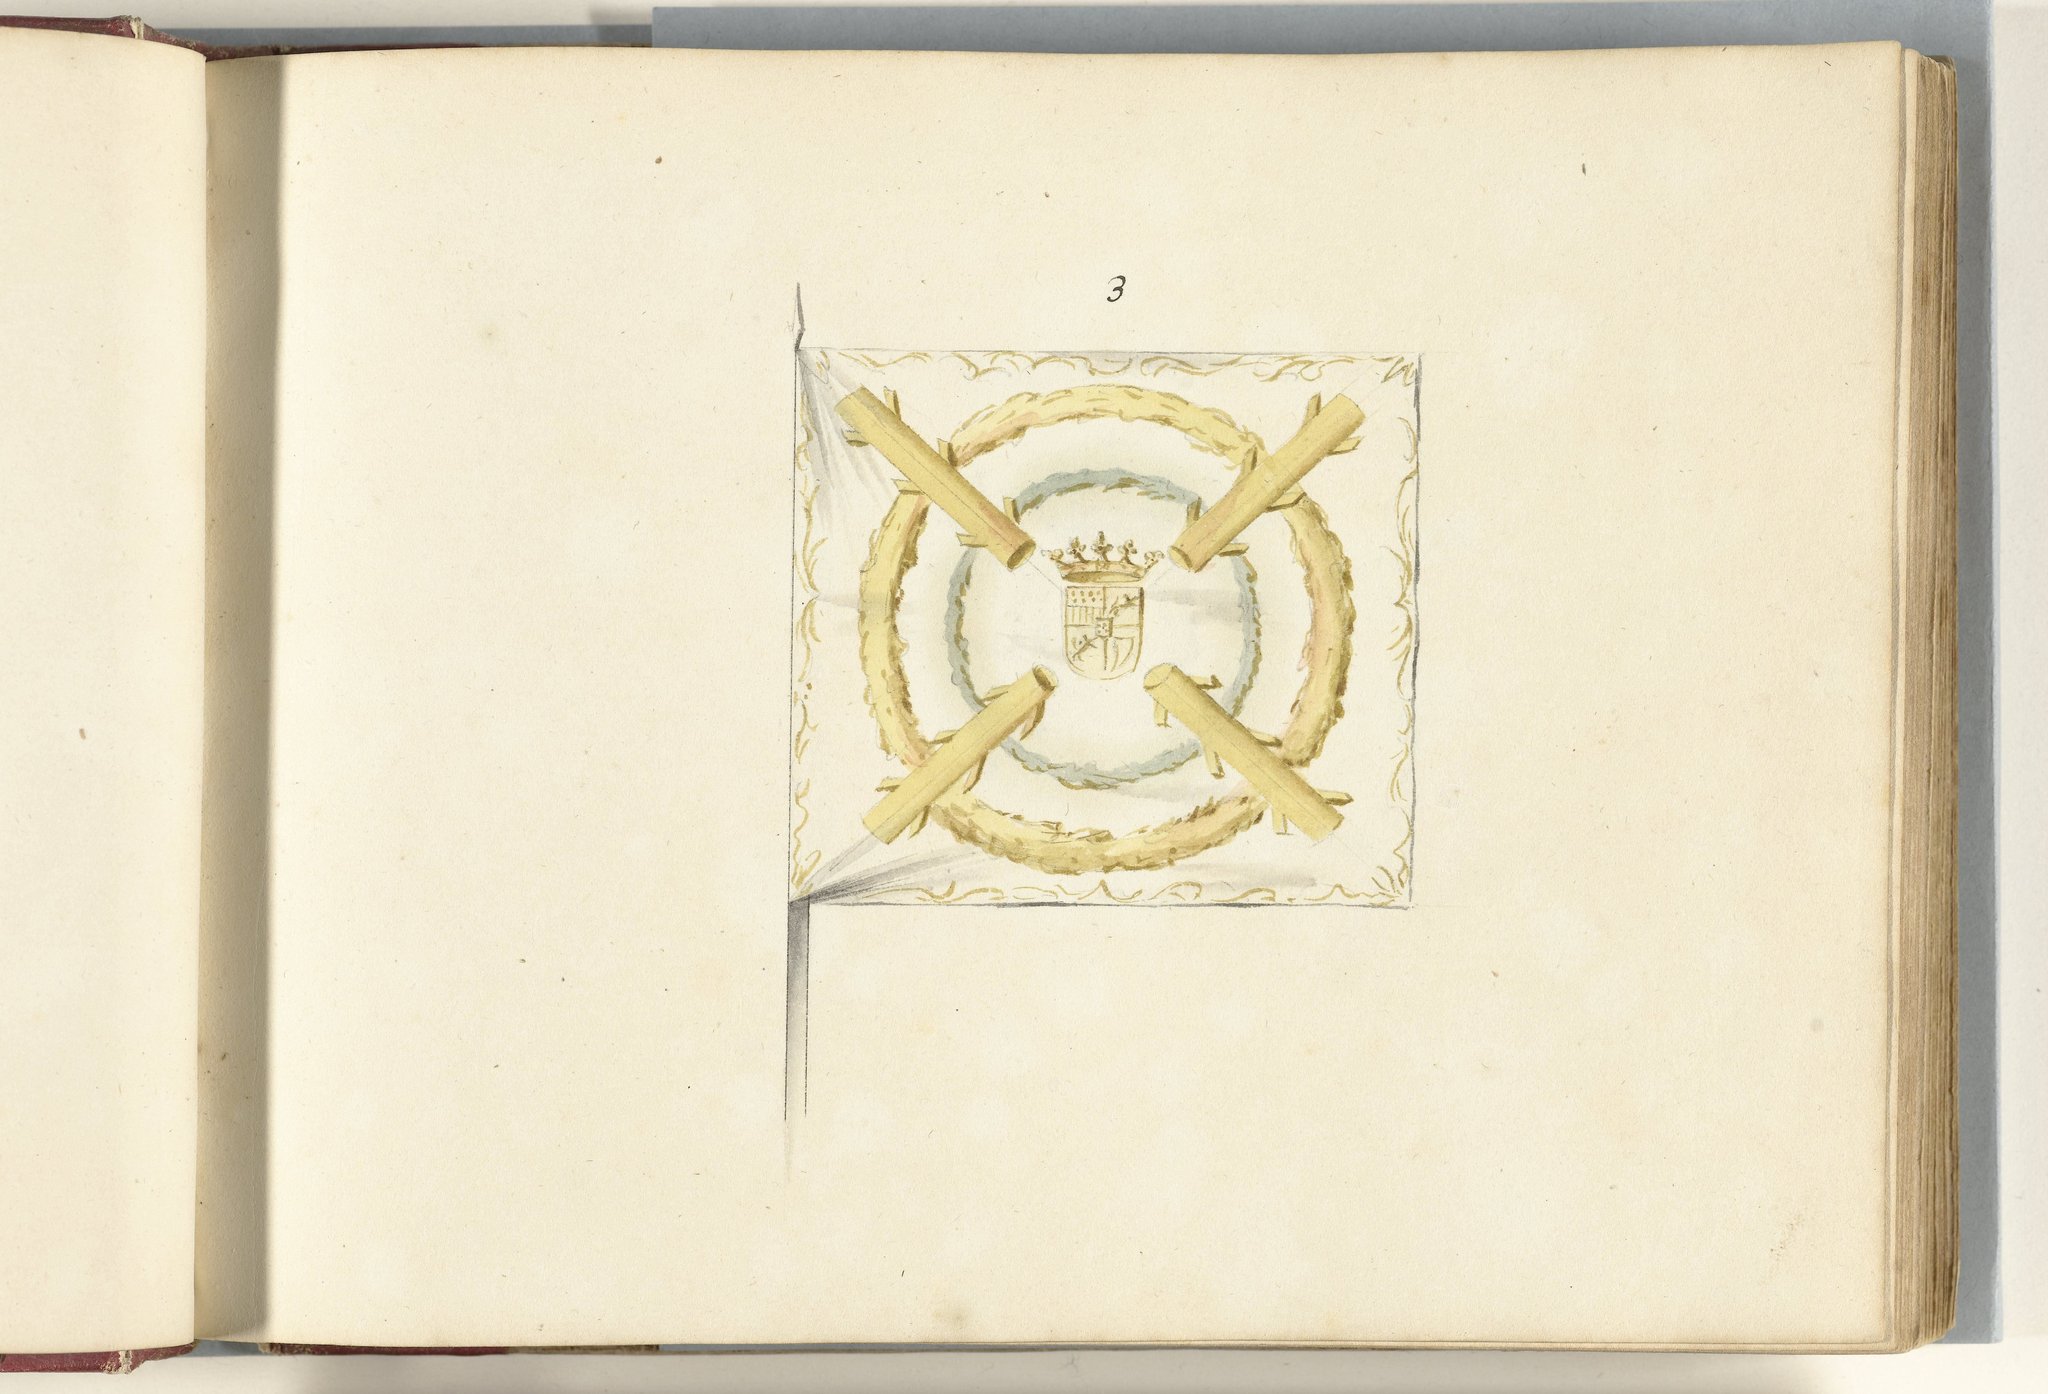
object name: drawing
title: Frans vaandel veroverd bij Oostende, 1706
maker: Anonymous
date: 1713-1720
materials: paper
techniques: drawing, writing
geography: northern netherlands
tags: (military) flags and standards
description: Frans vaandel veroverd bij Oostende, 1706. In het boek met tekeningen van Franse vaandels, standaarden en pauken, veroverd tijdens de Spaanse Successieoorlog (1701-1713).